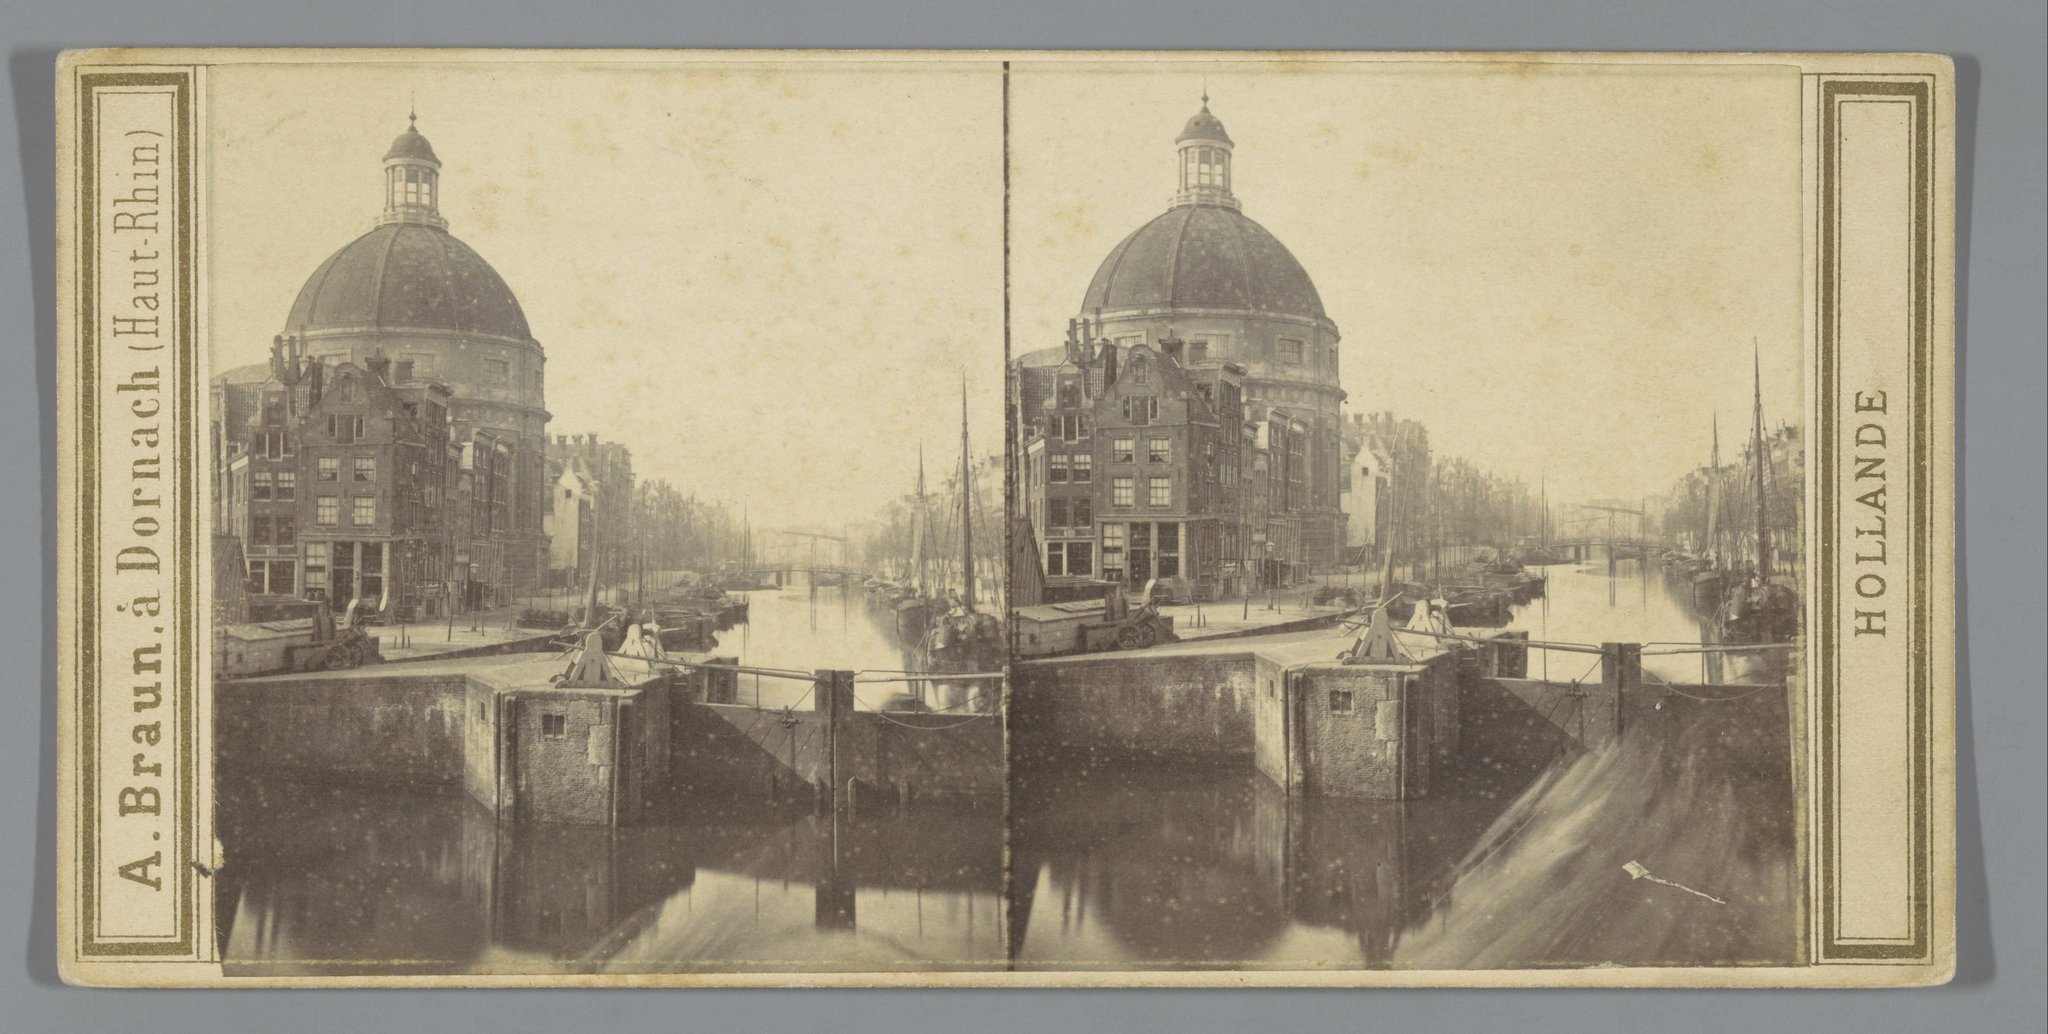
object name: stereograph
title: Hollande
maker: gaston braun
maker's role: fotograaf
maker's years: 1845-1928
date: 1864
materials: cardboard, paper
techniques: albumen print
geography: dornach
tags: canals, waters (in city)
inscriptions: number: ‘No 3920.’, number: ‘60’, inscription: ‘[...]/ No 6.’